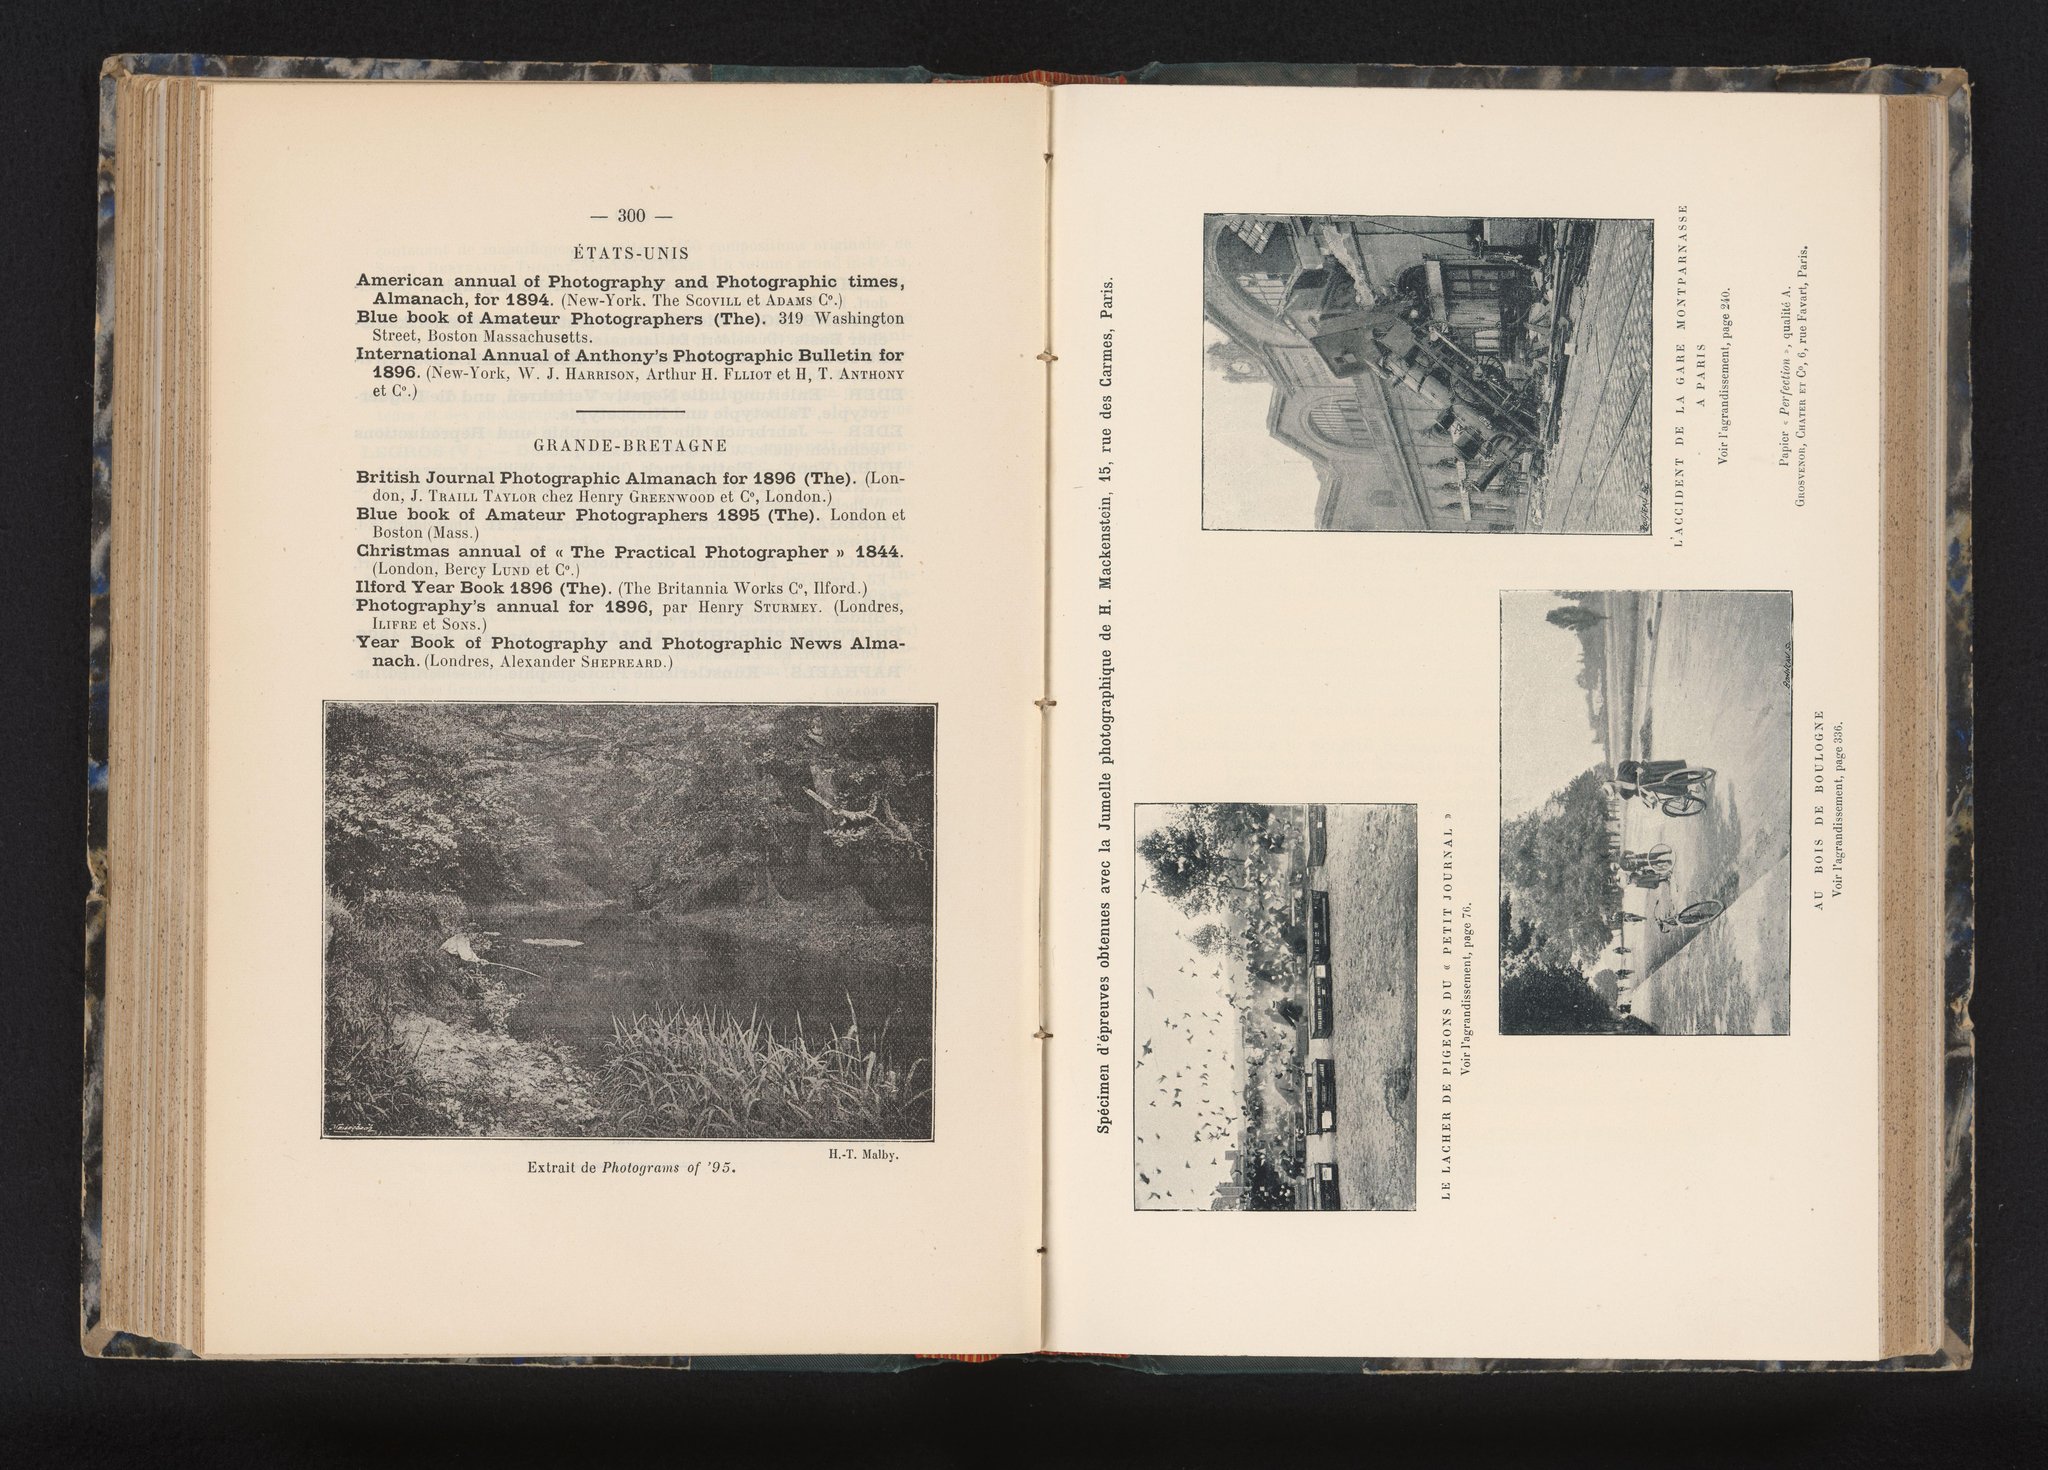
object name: photomechanical print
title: Mannen die duiven loslaten, treinongeluk op Gare Montparnasse op 22 oktober 1895 en fietsers in het Bois de Boulogne, Frankrijk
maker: Anonymous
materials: paper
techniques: autotype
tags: riding, cycling (recreation), accident with locomotive, doves, pigeons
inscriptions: inscription: ‘Voir l'agrandissement, page 336.’, inscription: ‘Voir l'agrandissement, page 76.’, inscription: ‘Papier < Perfection >, qualité A./ Grosvenor, Chater et Co, 6, rue Favart, Paris.’, inscription: ‘Voir l'agrandissement, page 240.’, inscription: ‘Spécimen d'épreuves obtenues avec la Jumelle photographique de H. Mackenstein, 15, rue des Carmes, Paris.’